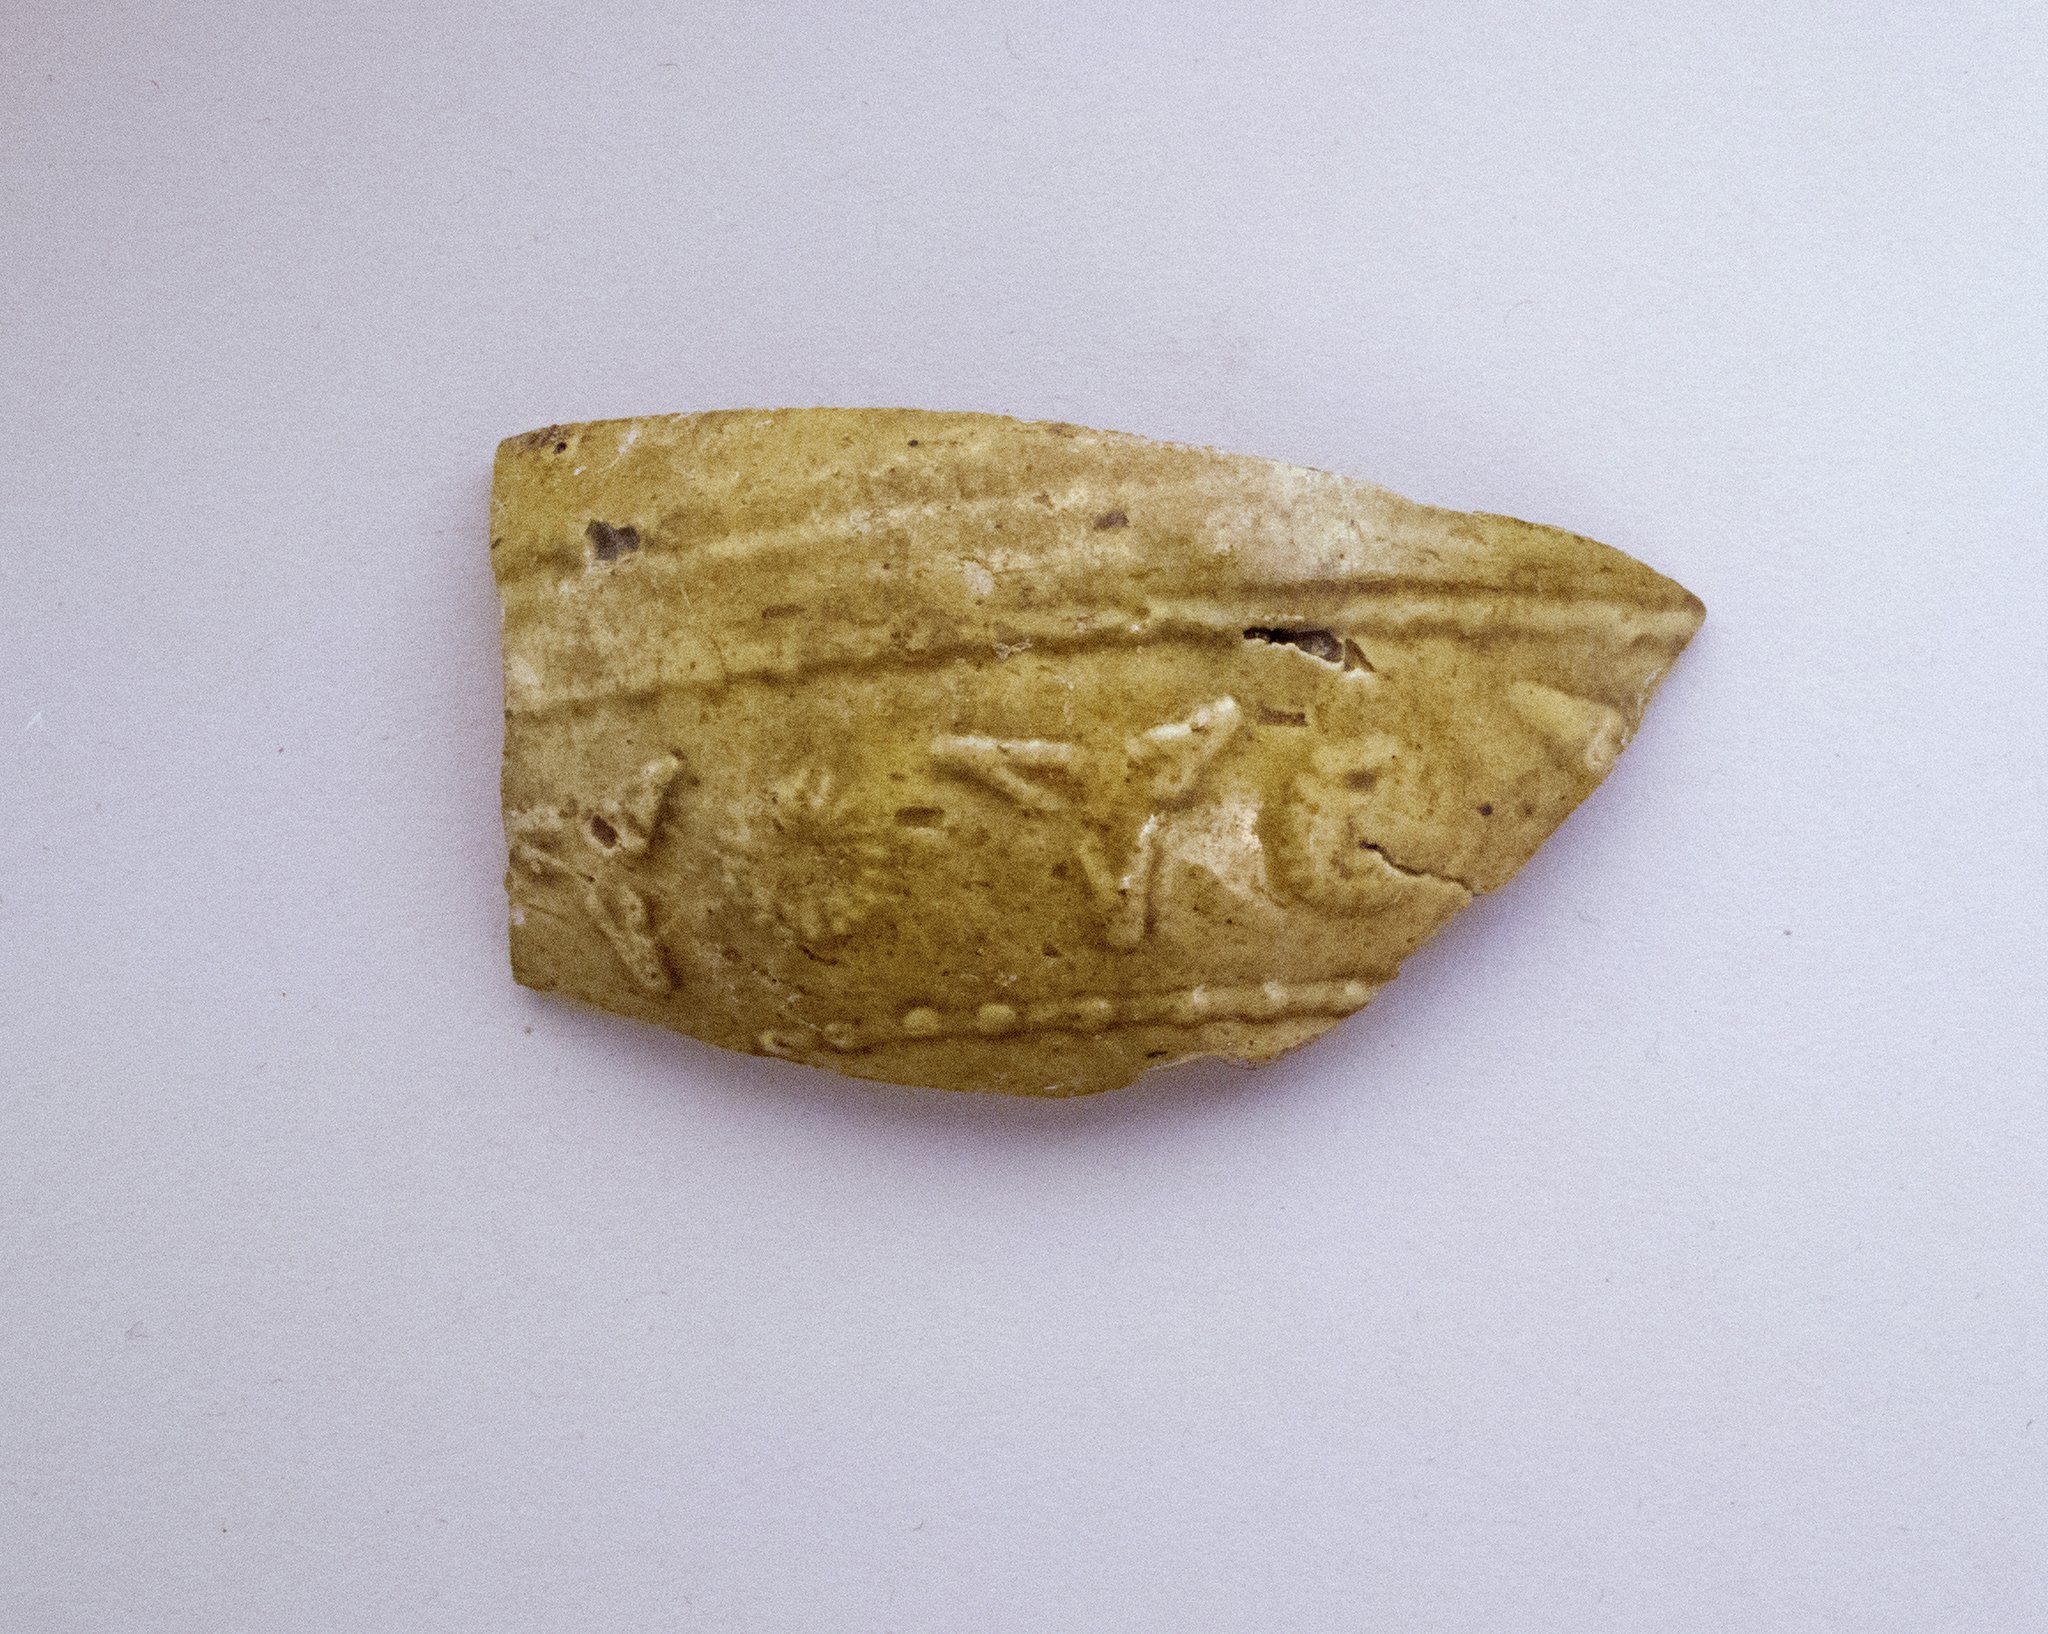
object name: vase fragment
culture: roman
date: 670 BCE-330 CE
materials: terracotta